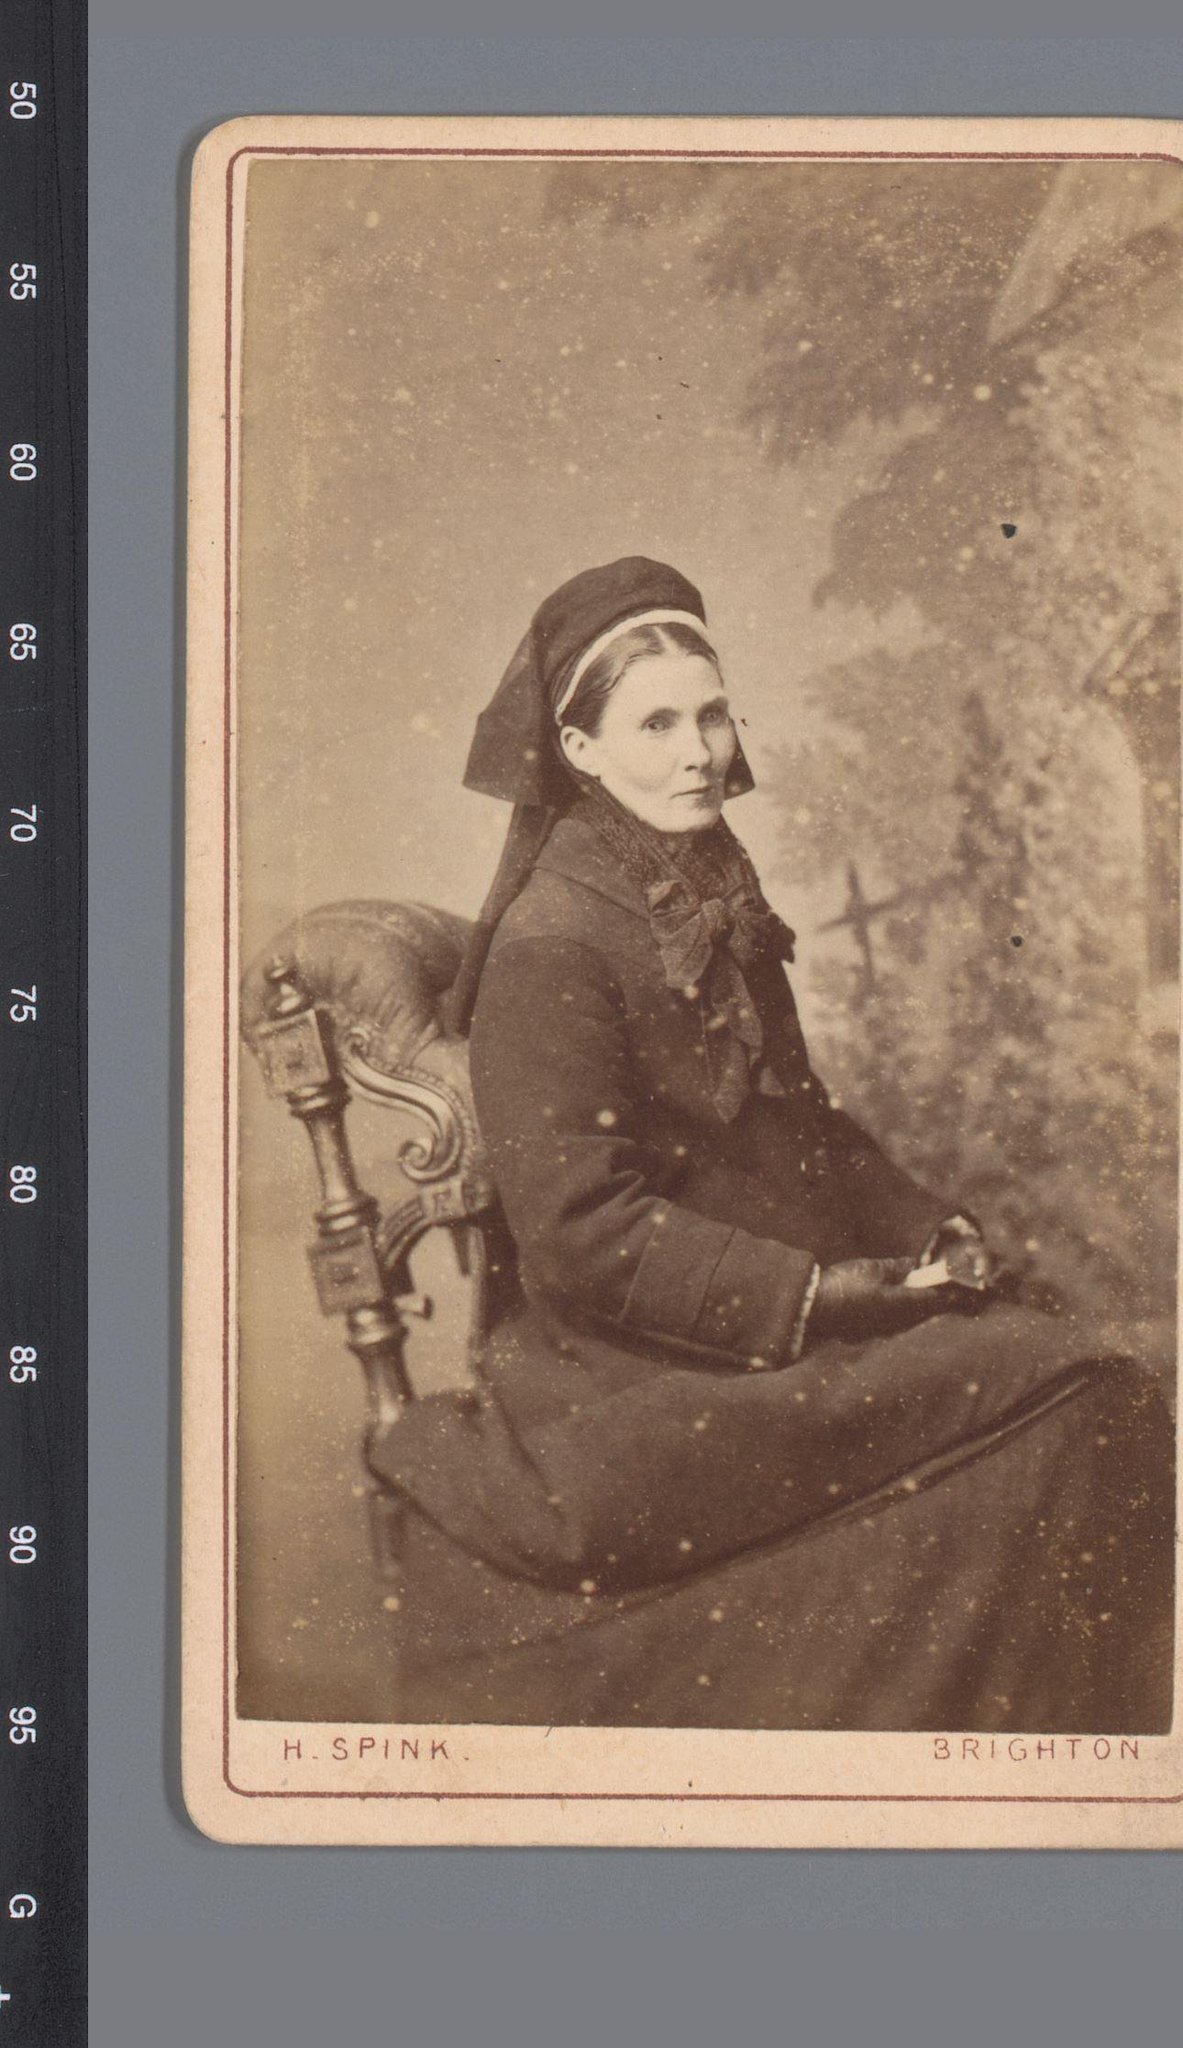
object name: carte de visite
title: Portret van een onbekende vrouw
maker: henry joseph spink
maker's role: fotograaf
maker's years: 1840-1892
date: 1878-1890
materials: cardboard, paper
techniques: albumen print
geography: brighton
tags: adult woman, anonymous historical person portrayed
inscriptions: inscription: ‘FURTHER/ COPIES MAY ALWAYS BE HAD/ BY SENDING NAME & DATE OF SITTING/ This or any other Portrait enlarged up to life/ size and painted on Oil or Water colors to order’, address: ‘109, WESTERN Rd BRIGHTON/ Goldstone Villas,/ Cliftonville,/ Brighton.’